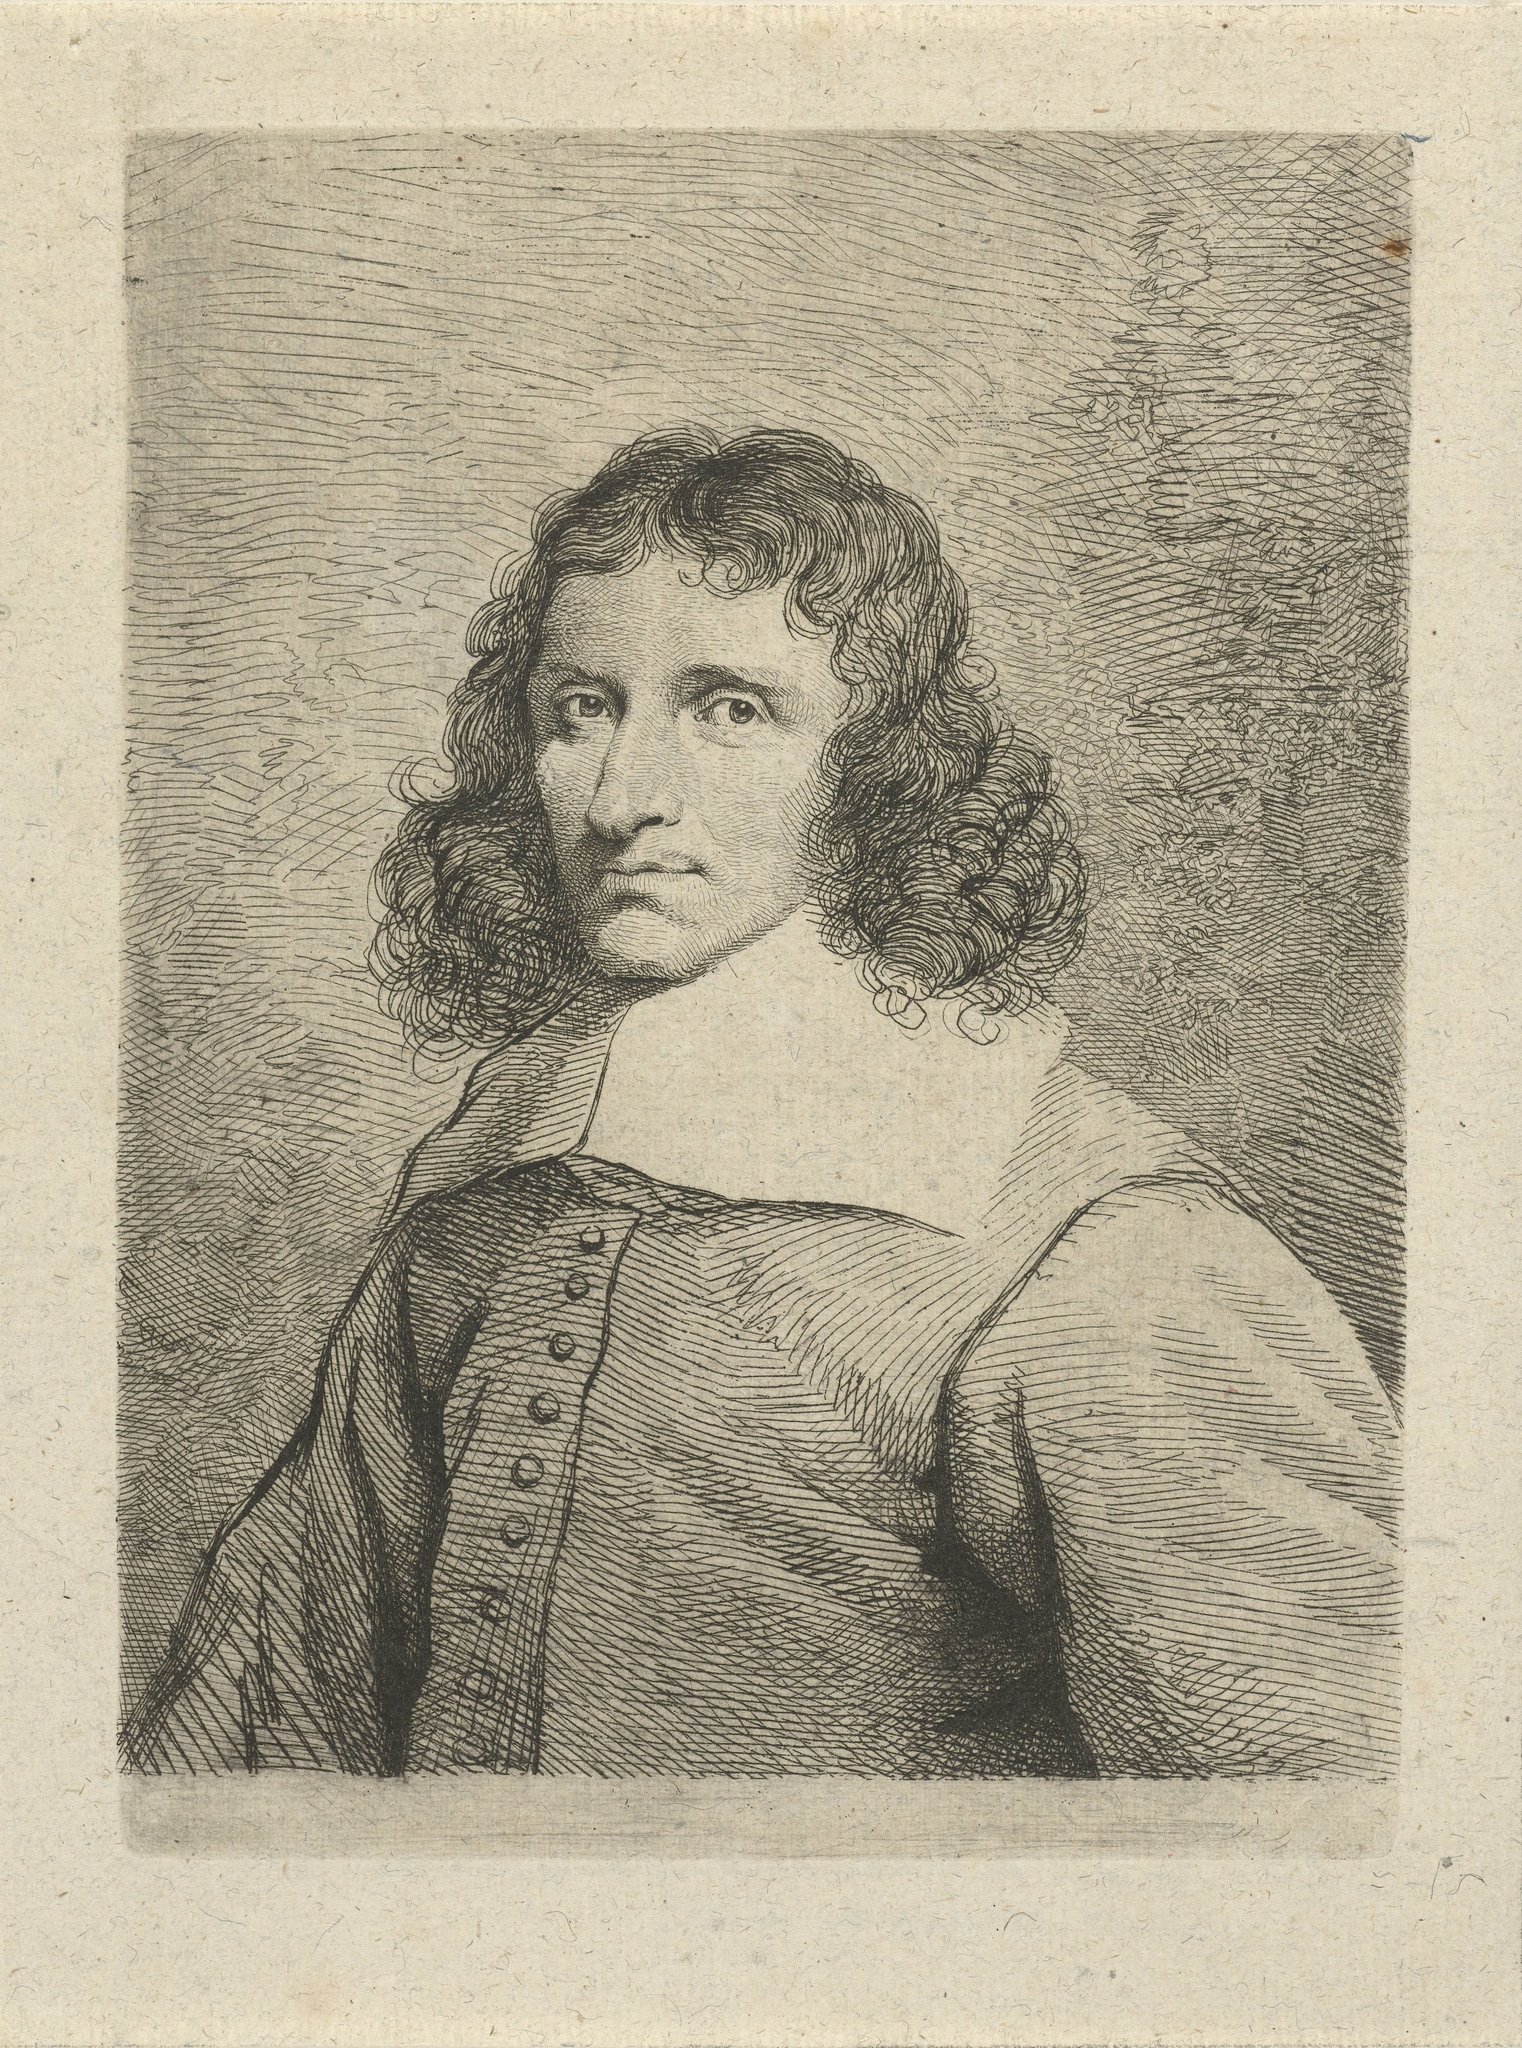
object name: print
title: Portret van Cornelis van Dalen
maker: johannes pieter de frey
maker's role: draughtsman, print maker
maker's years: 1770-1834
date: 1801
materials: paper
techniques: etching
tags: cornelis van dalen, portrait, self-portrait of artist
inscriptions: collector's mark: Lugt 2228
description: Portret van kunstenaar Cornelis van Dalen, ten halven lijve naar links.